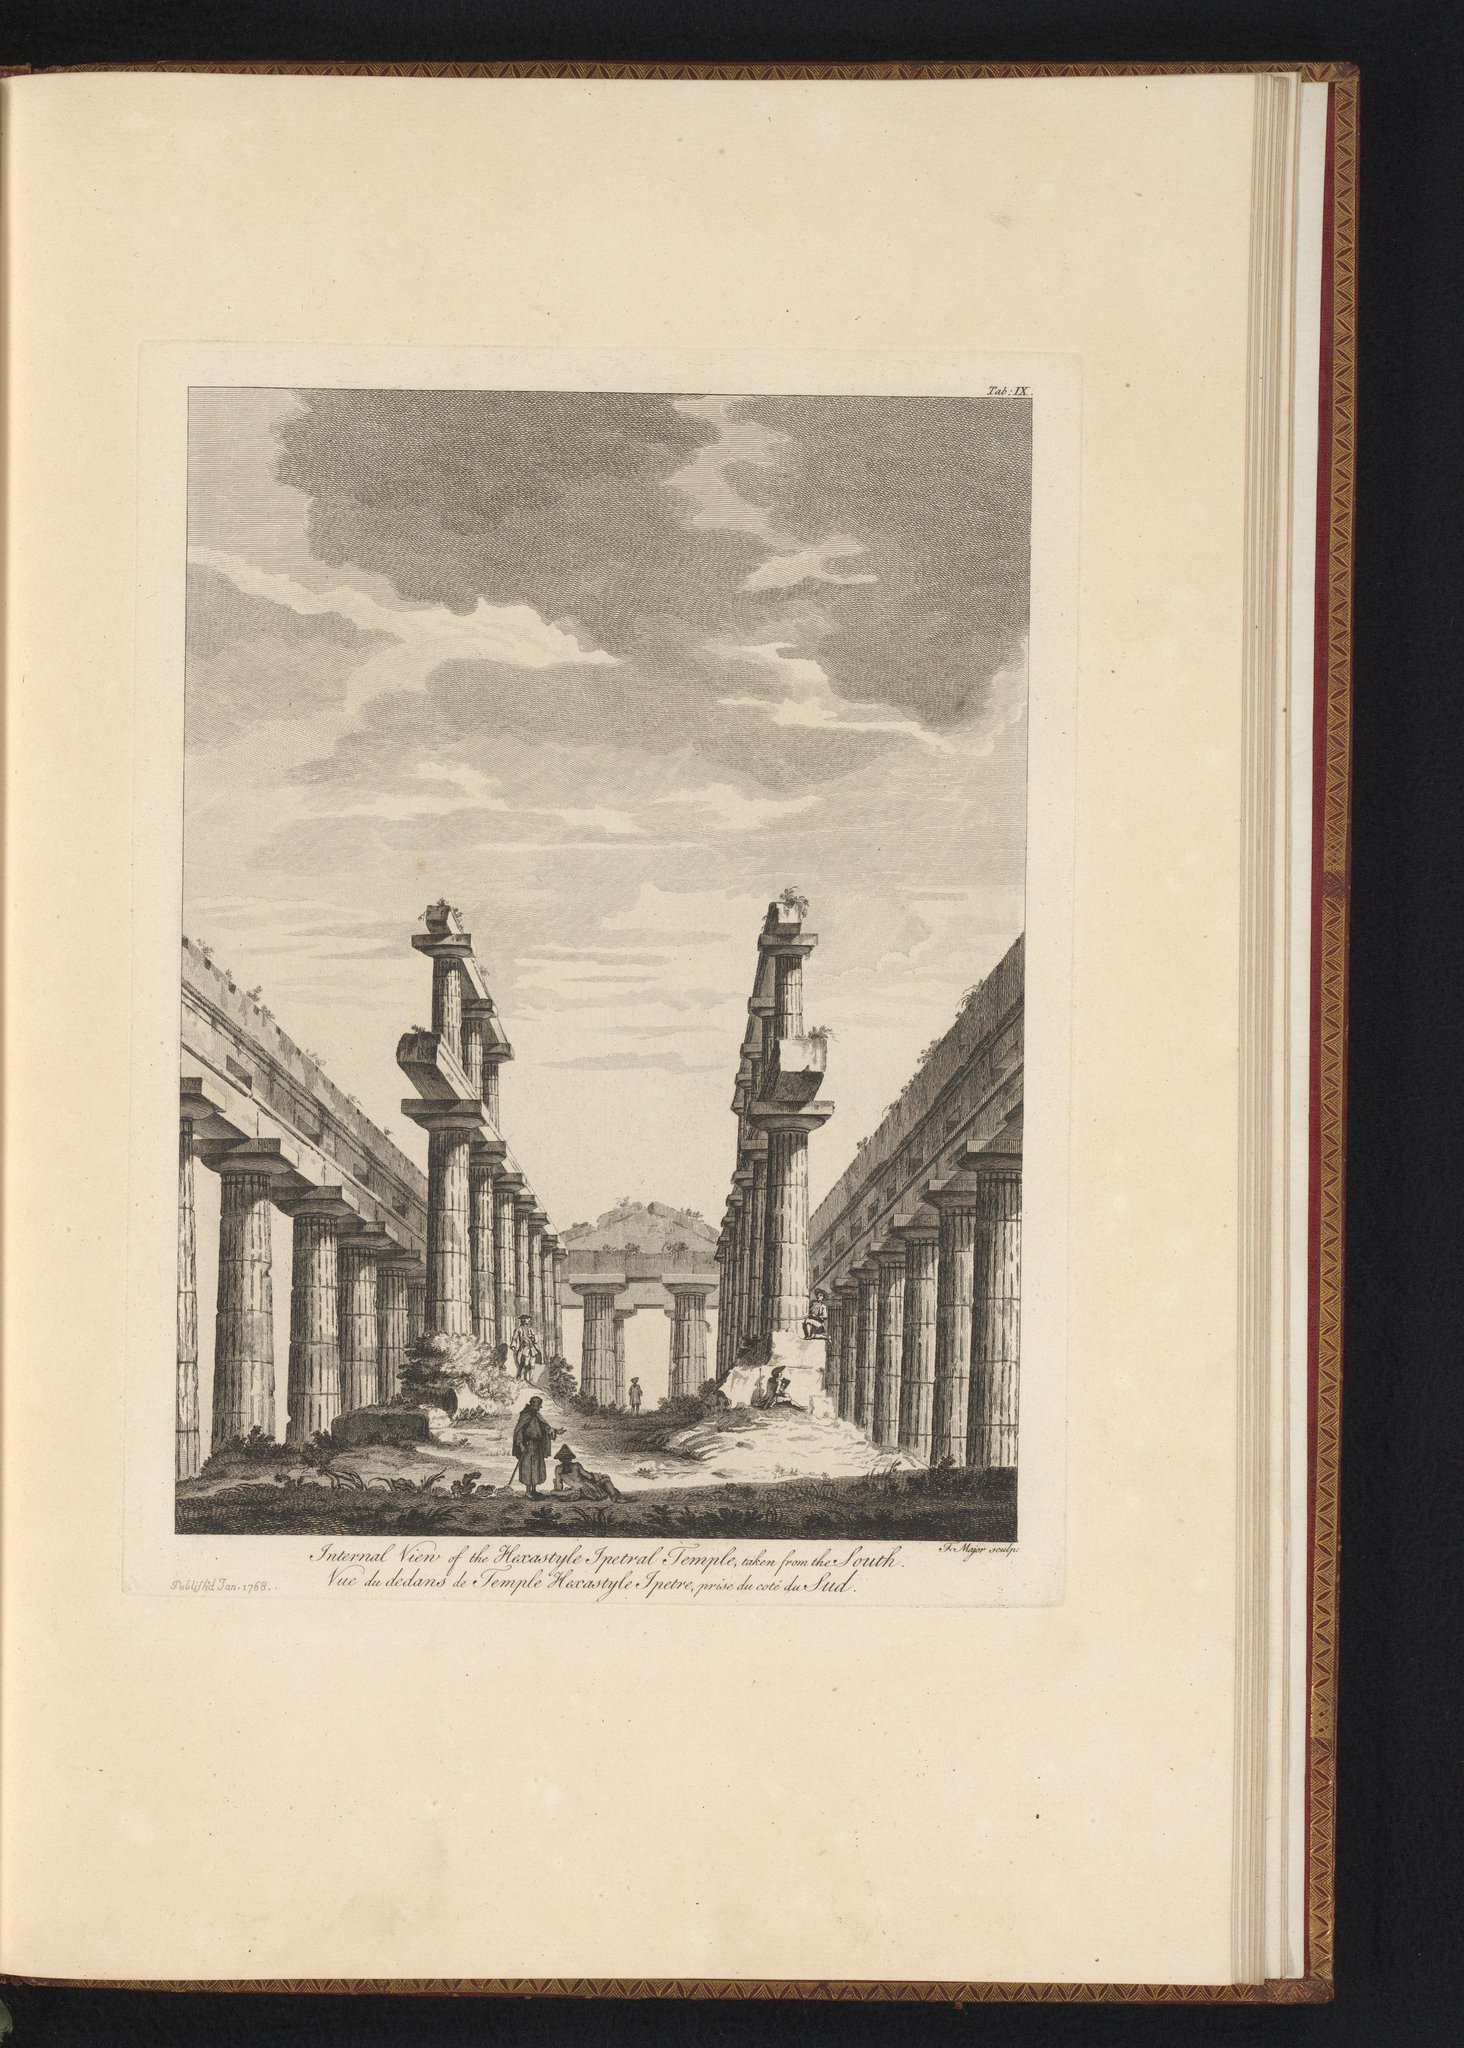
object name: page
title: Gezicht op de ruïne vanuit de tempel gezien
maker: thomas major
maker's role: print maker, publisher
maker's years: 1714-1799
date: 1768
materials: paper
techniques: engraving, etching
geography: london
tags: landscape with ruins (+ city(-scape) with figures, staffage), temple, shrine ~ greek religion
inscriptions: date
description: Deze prent is onderdeel van de reeks van 25 genummerde illustraties in deze uitgave.